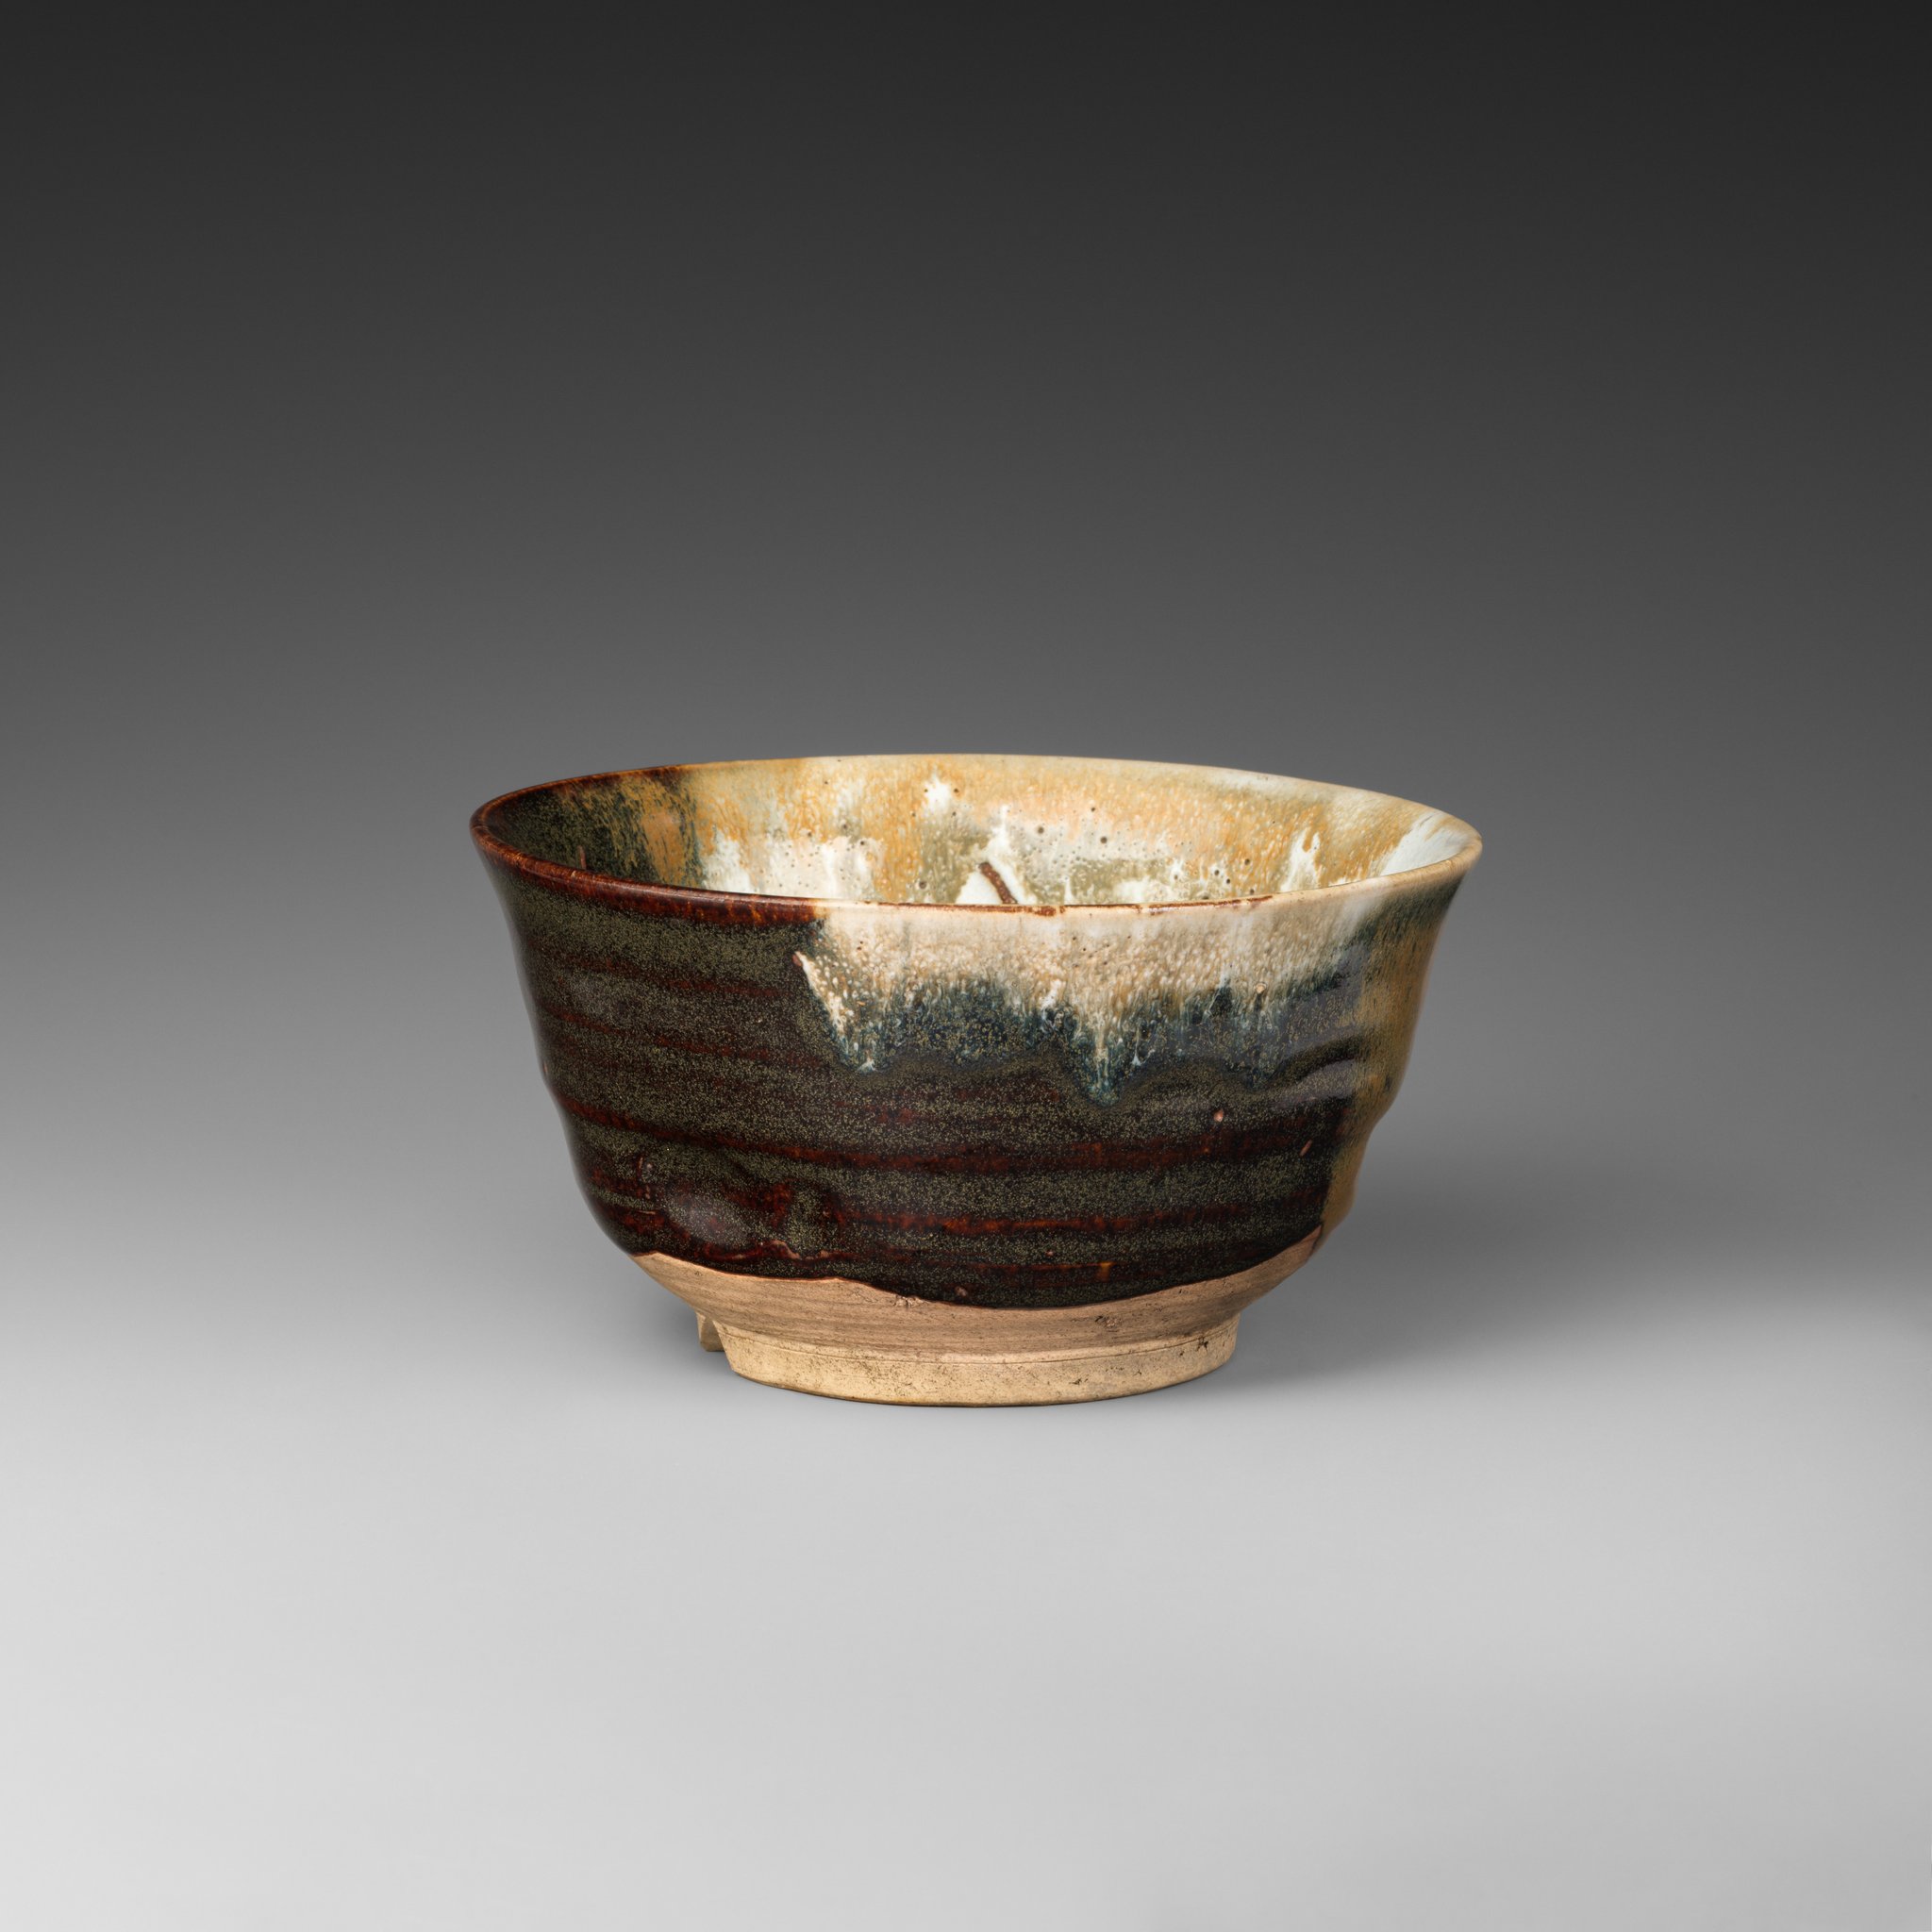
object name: teabowl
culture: japanese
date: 1801-1900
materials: clay, glaze